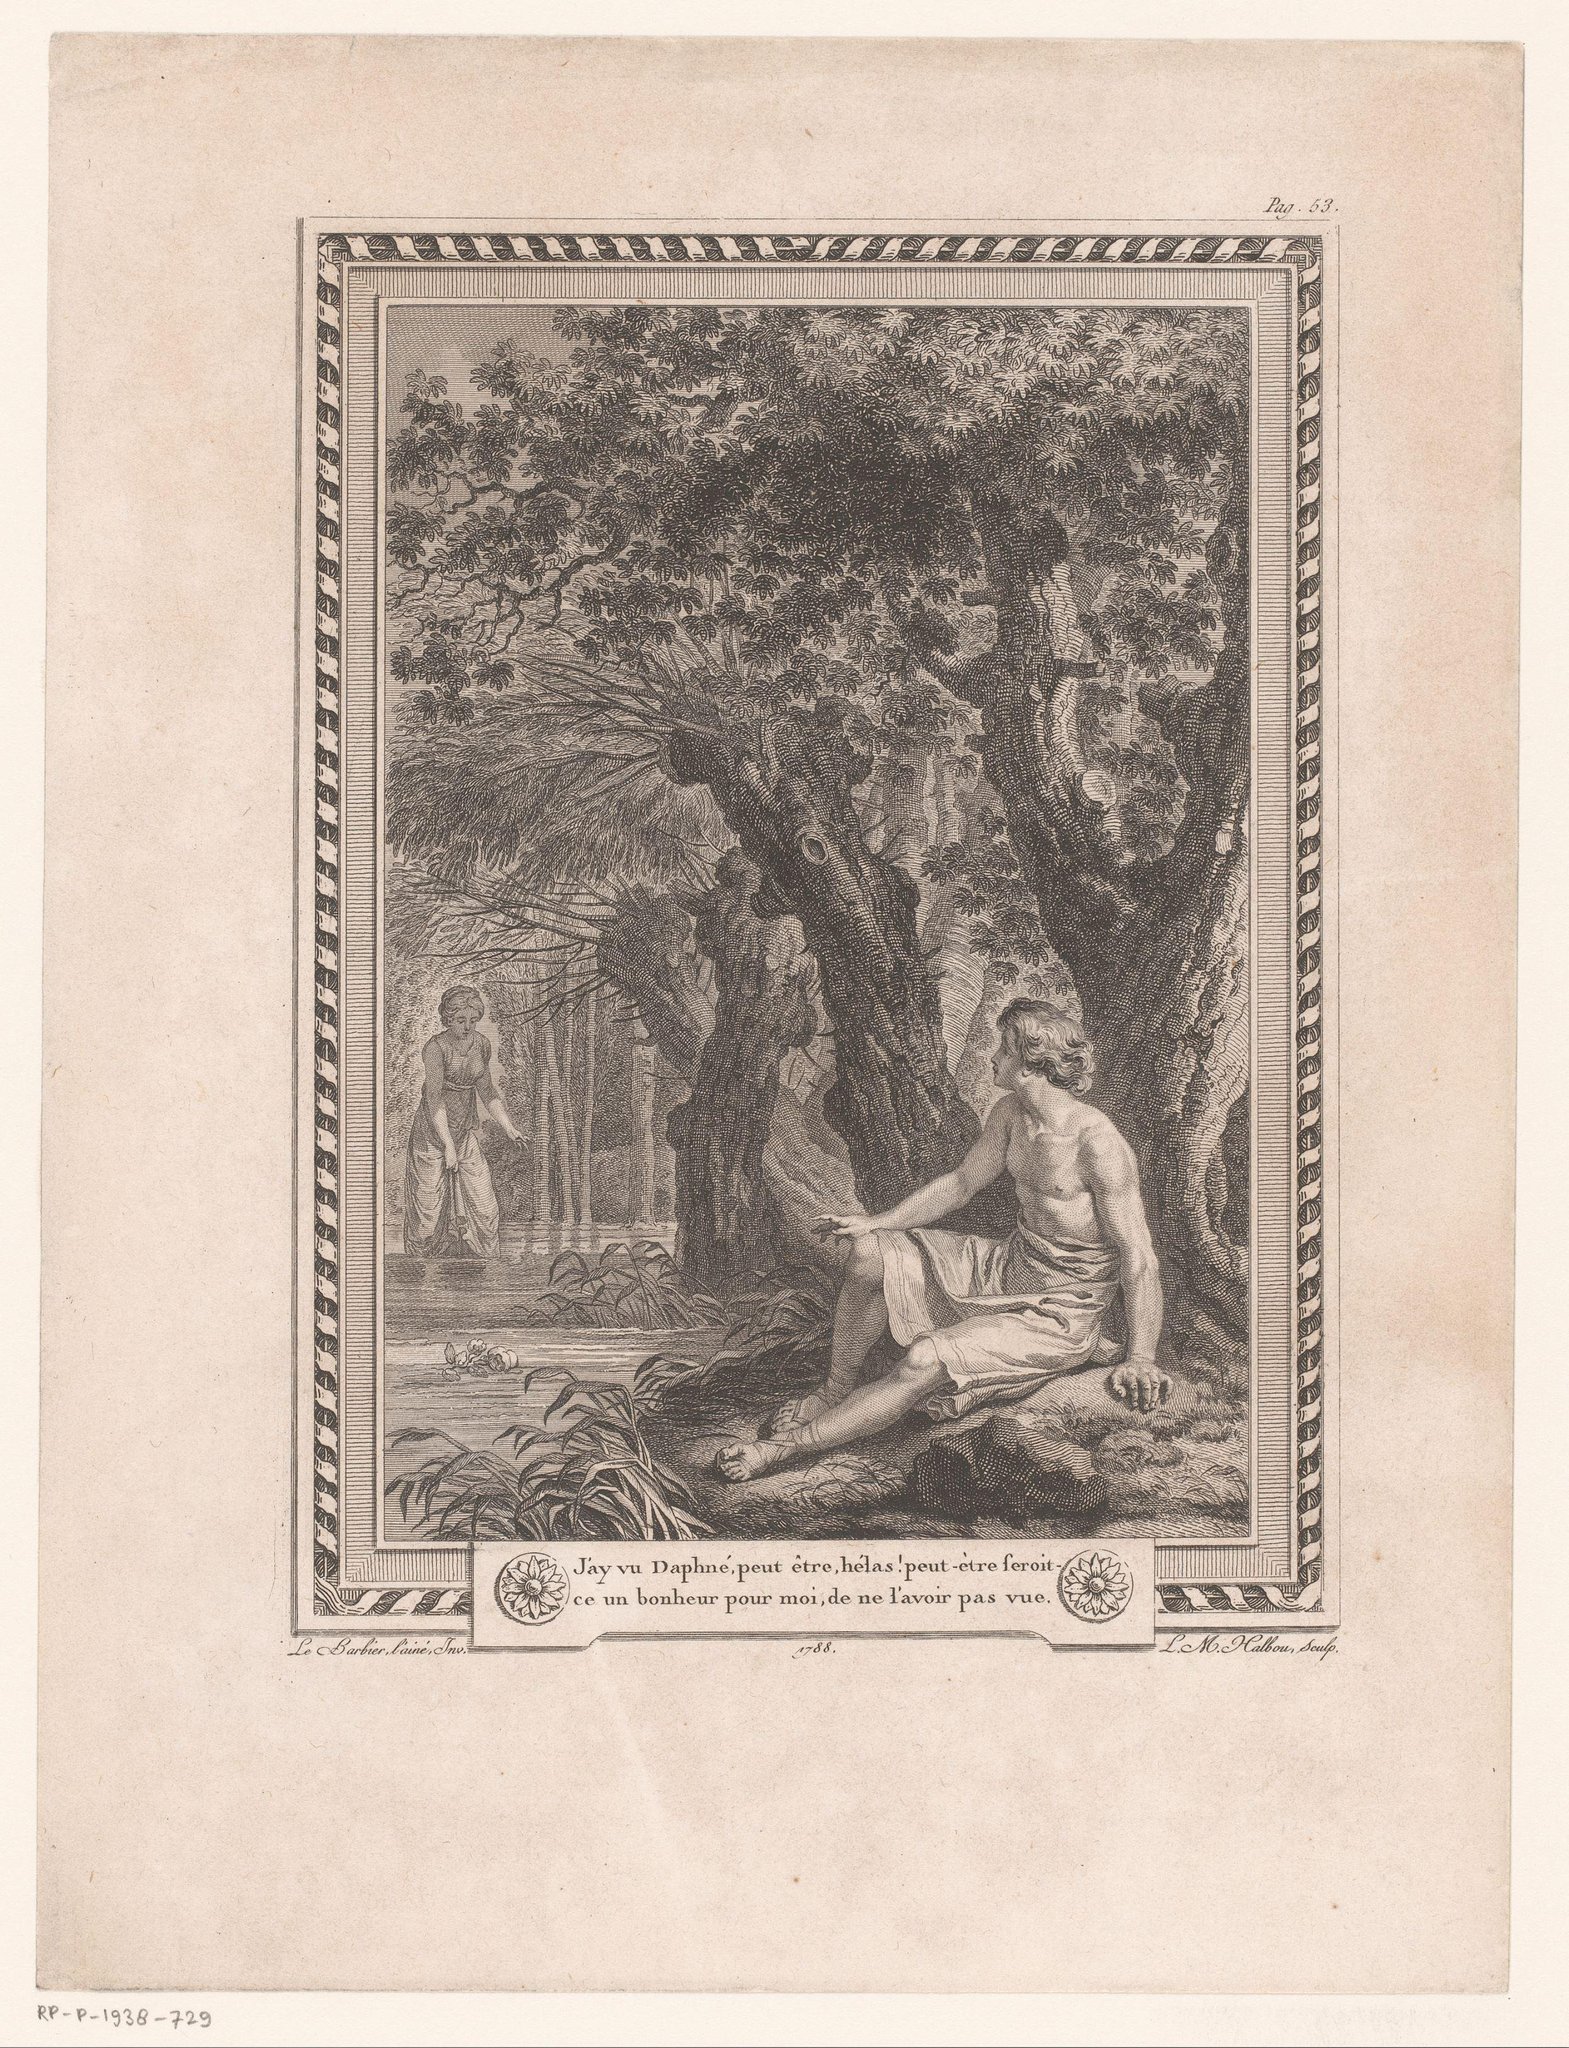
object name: print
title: Daphne in het water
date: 1788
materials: paper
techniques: engraving, etching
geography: paris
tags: public baths - aa - in the open air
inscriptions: collector's mark: Lugt 2228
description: Prent uit: Oeuvres de Salomon Gessner. Parijs: Le Barbier, Veuve Hérissant & Barrois aîné, 1786-1793. Dit boek betreft een verzameling van de werken van Salomon Gessner, vertaald door Huber, Meister en Bruté de Loirelle en gepubliceerd in drie delen.